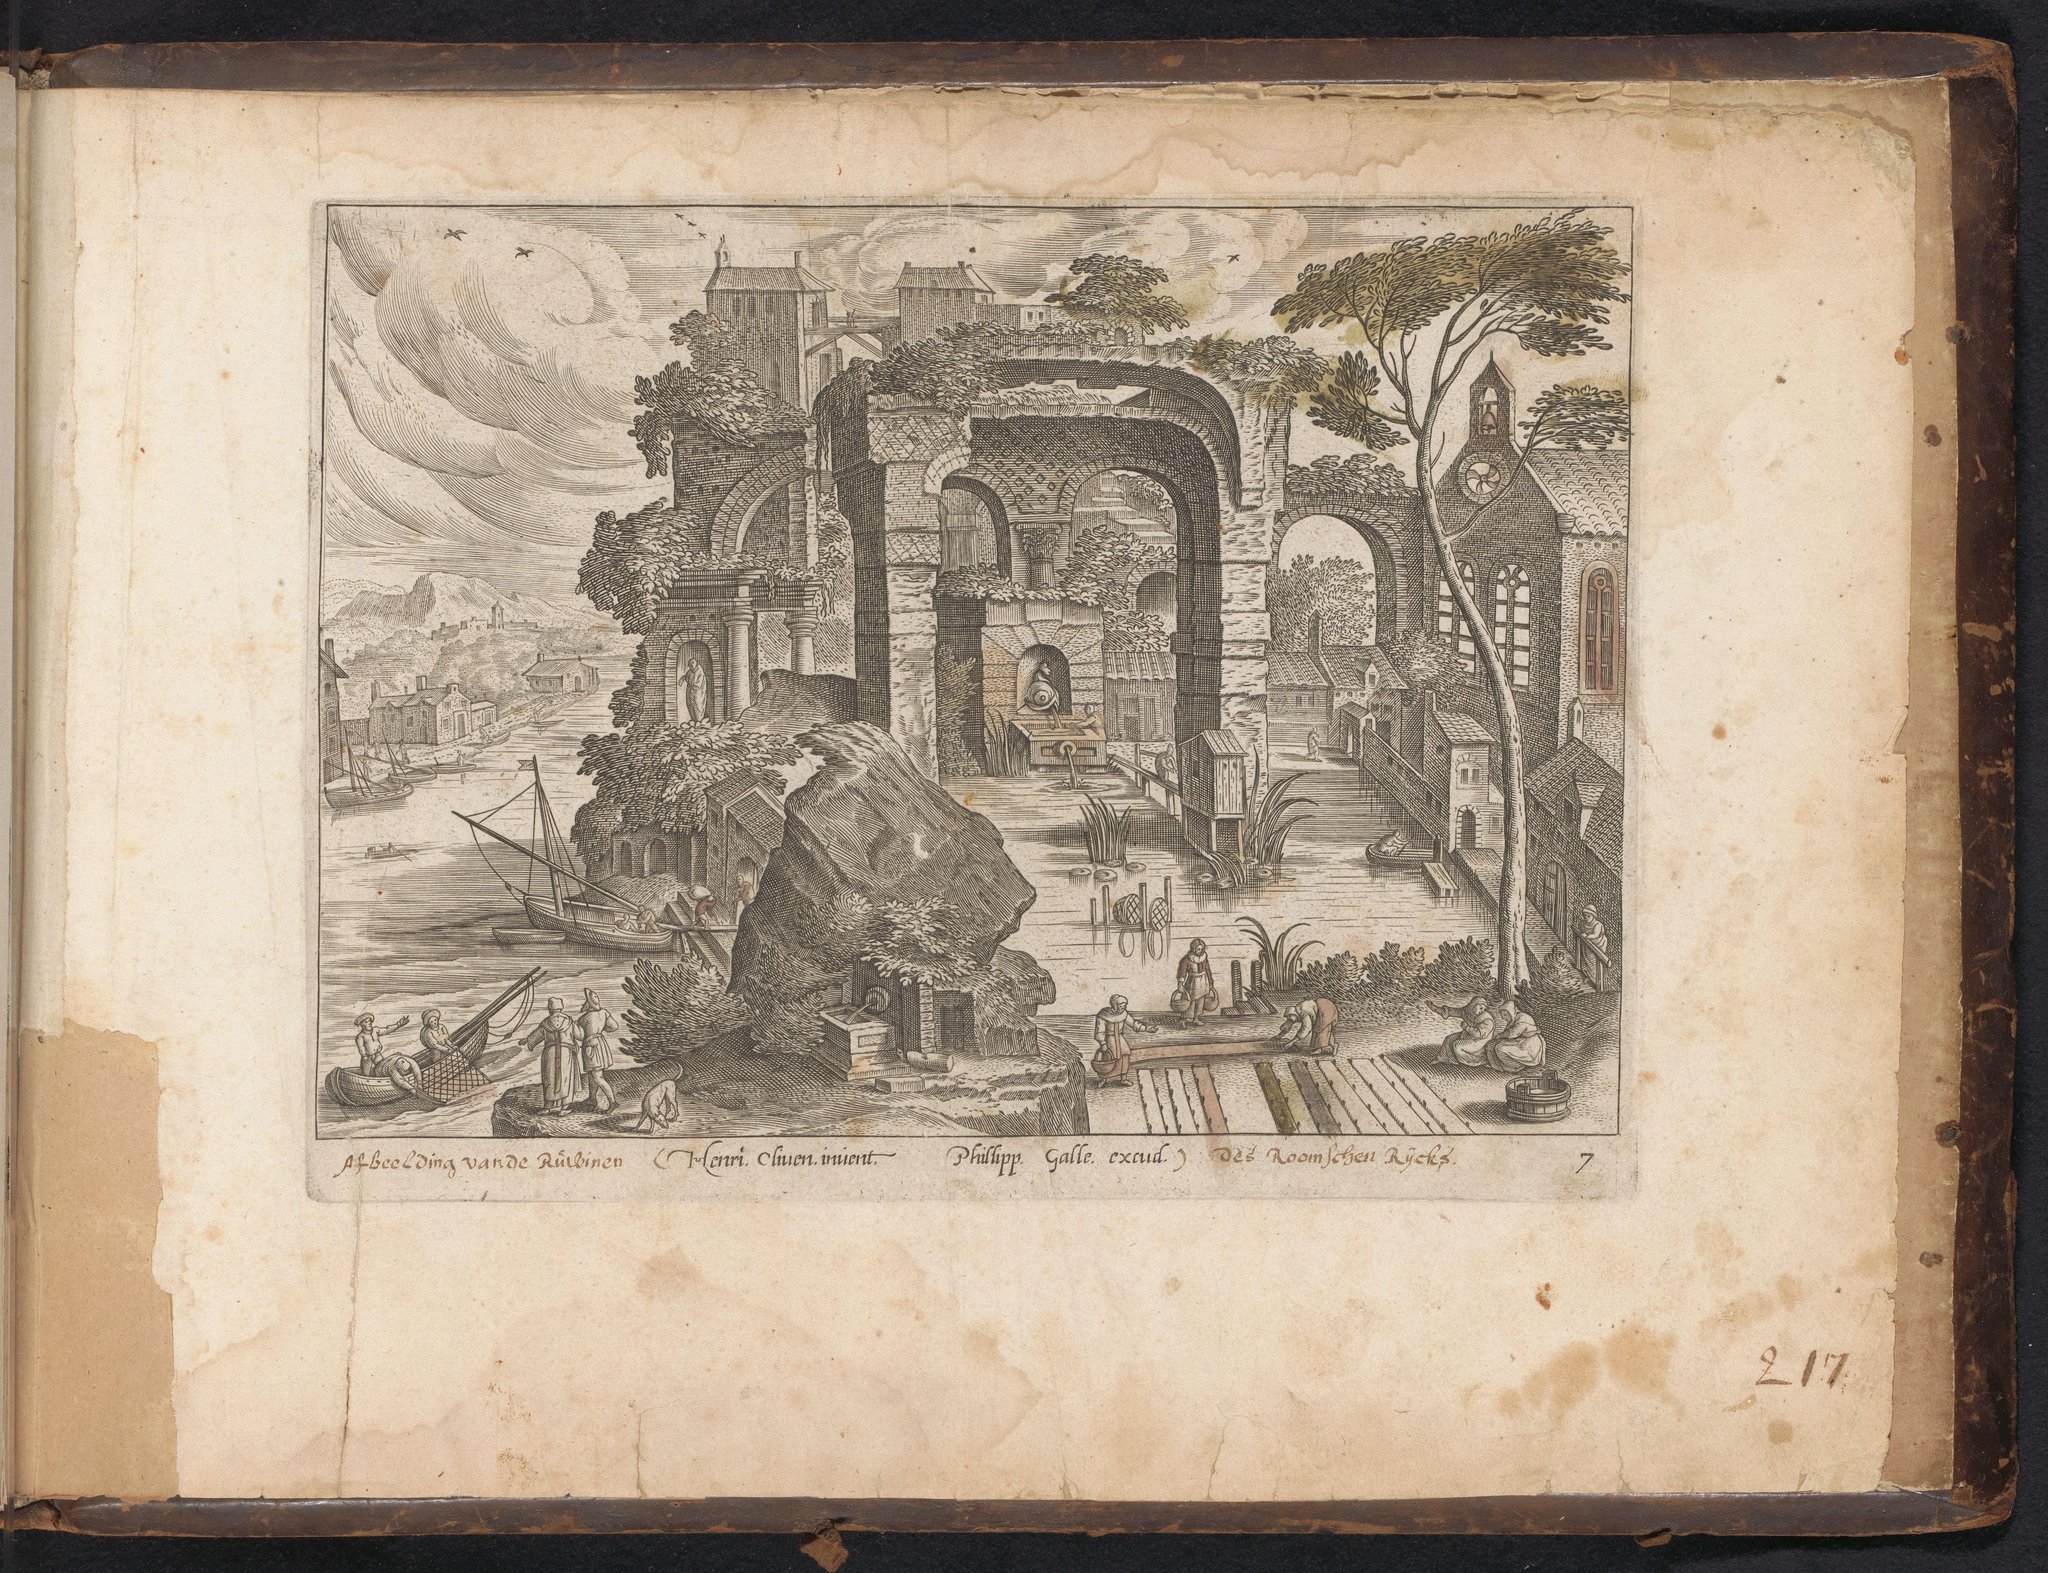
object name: album leaf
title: Den Grooten Figuer-Bibel (...)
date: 1587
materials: paper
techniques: engraving, hand coloring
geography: alkmaar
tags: river (+ landscape with figures, staffage), landscape with ruins (+ city(-scape) with figures, staffage)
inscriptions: number: ‘217’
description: Op de voorgrond de oever van een rivier. Naast de oever staat een grote ruïne met een vijver in het midden. De prent maakt deel uit van een album.